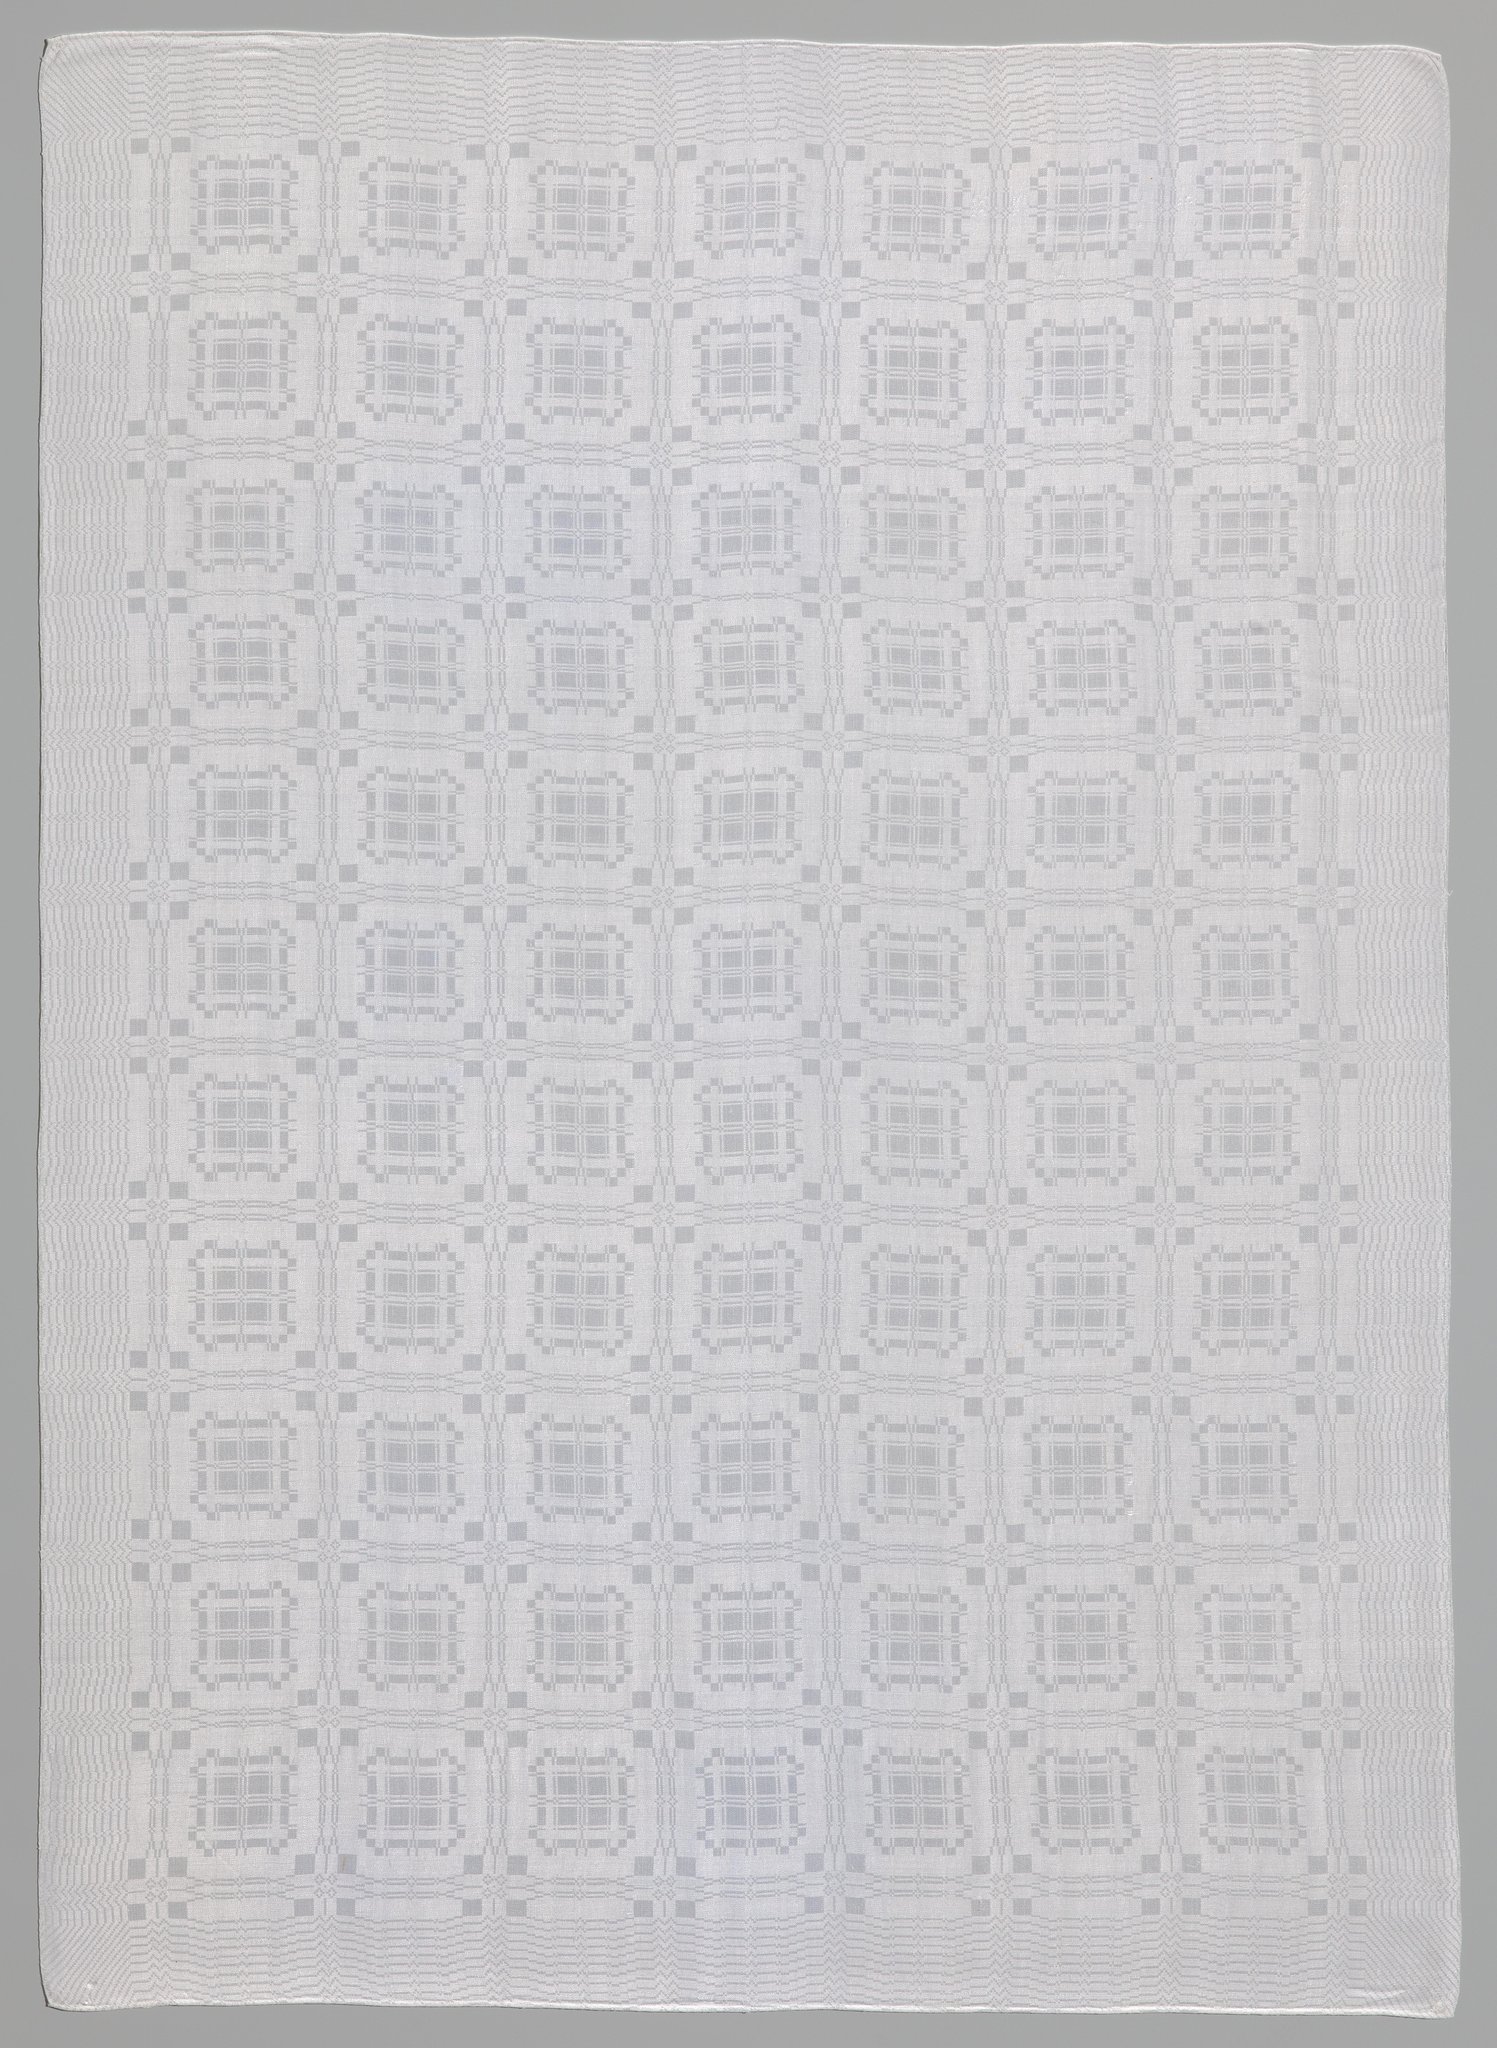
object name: napkin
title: Servet van linnen met pellenpatroon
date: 1400-1950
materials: linen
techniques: peeled fabric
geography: northern netherlands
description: Wit linnendamasten servet met pellenpatroon, merk kroon IS en 36.